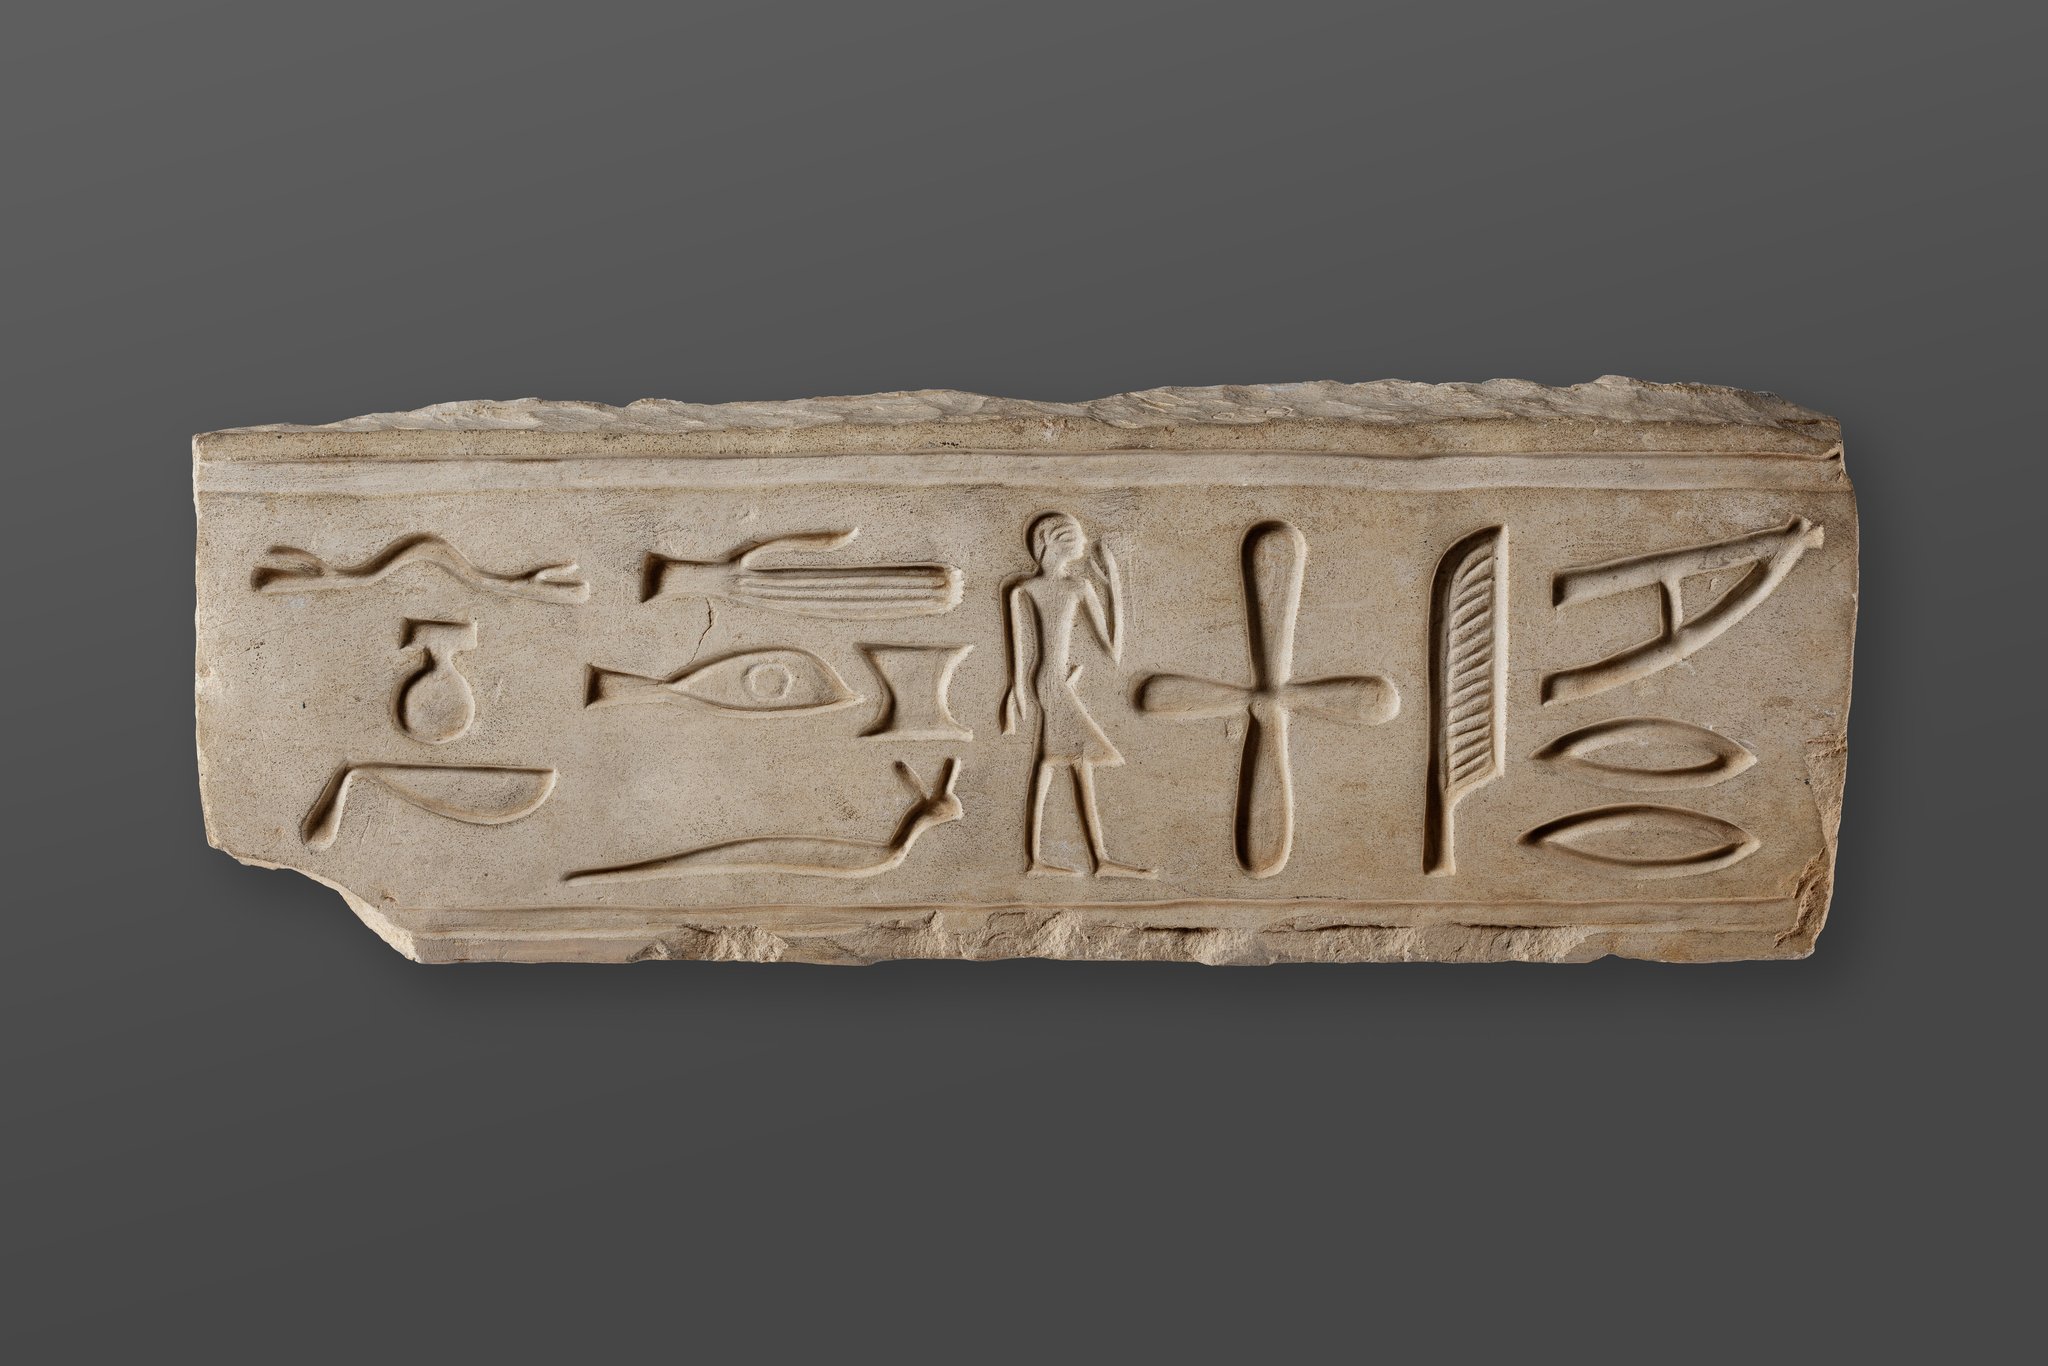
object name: relief fragment, tomb of mereri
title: Frieze from the tomb of Mereri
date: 2100-2030 BCE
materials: limestone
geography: egypt